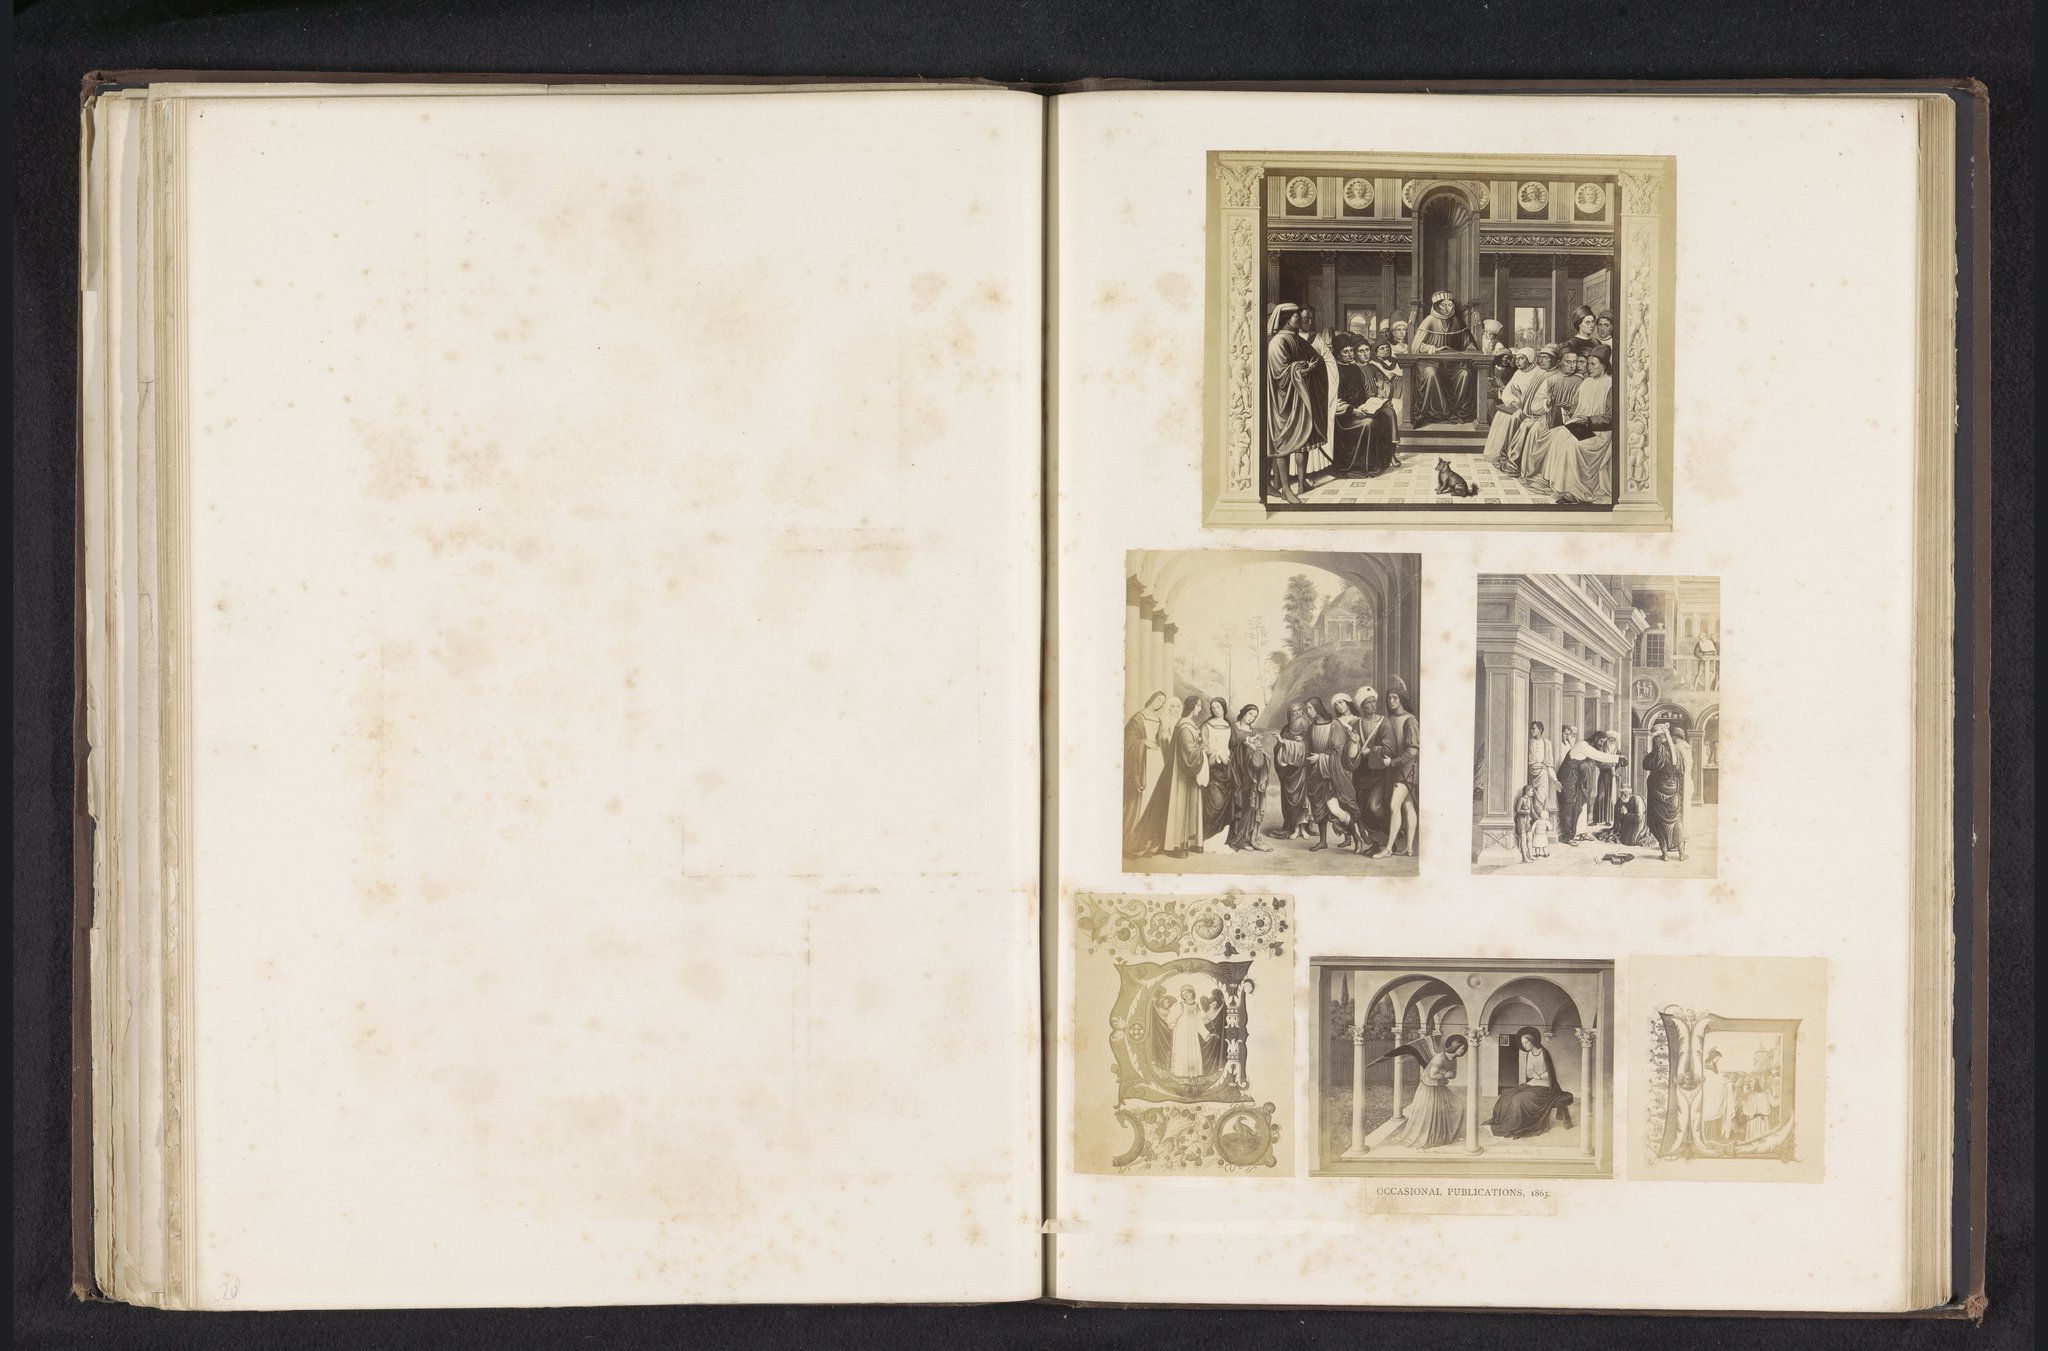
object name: page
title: Zes fotoreproducties van een publicatie door de Arundel Society met schilderijen en miniaturen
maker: Anonymous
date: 1859-1869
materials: photographic support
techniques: albumen print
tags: book, painting (including book-illumination, miniature-painting)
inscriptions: inscription: ‘occasional publications, 1863.’